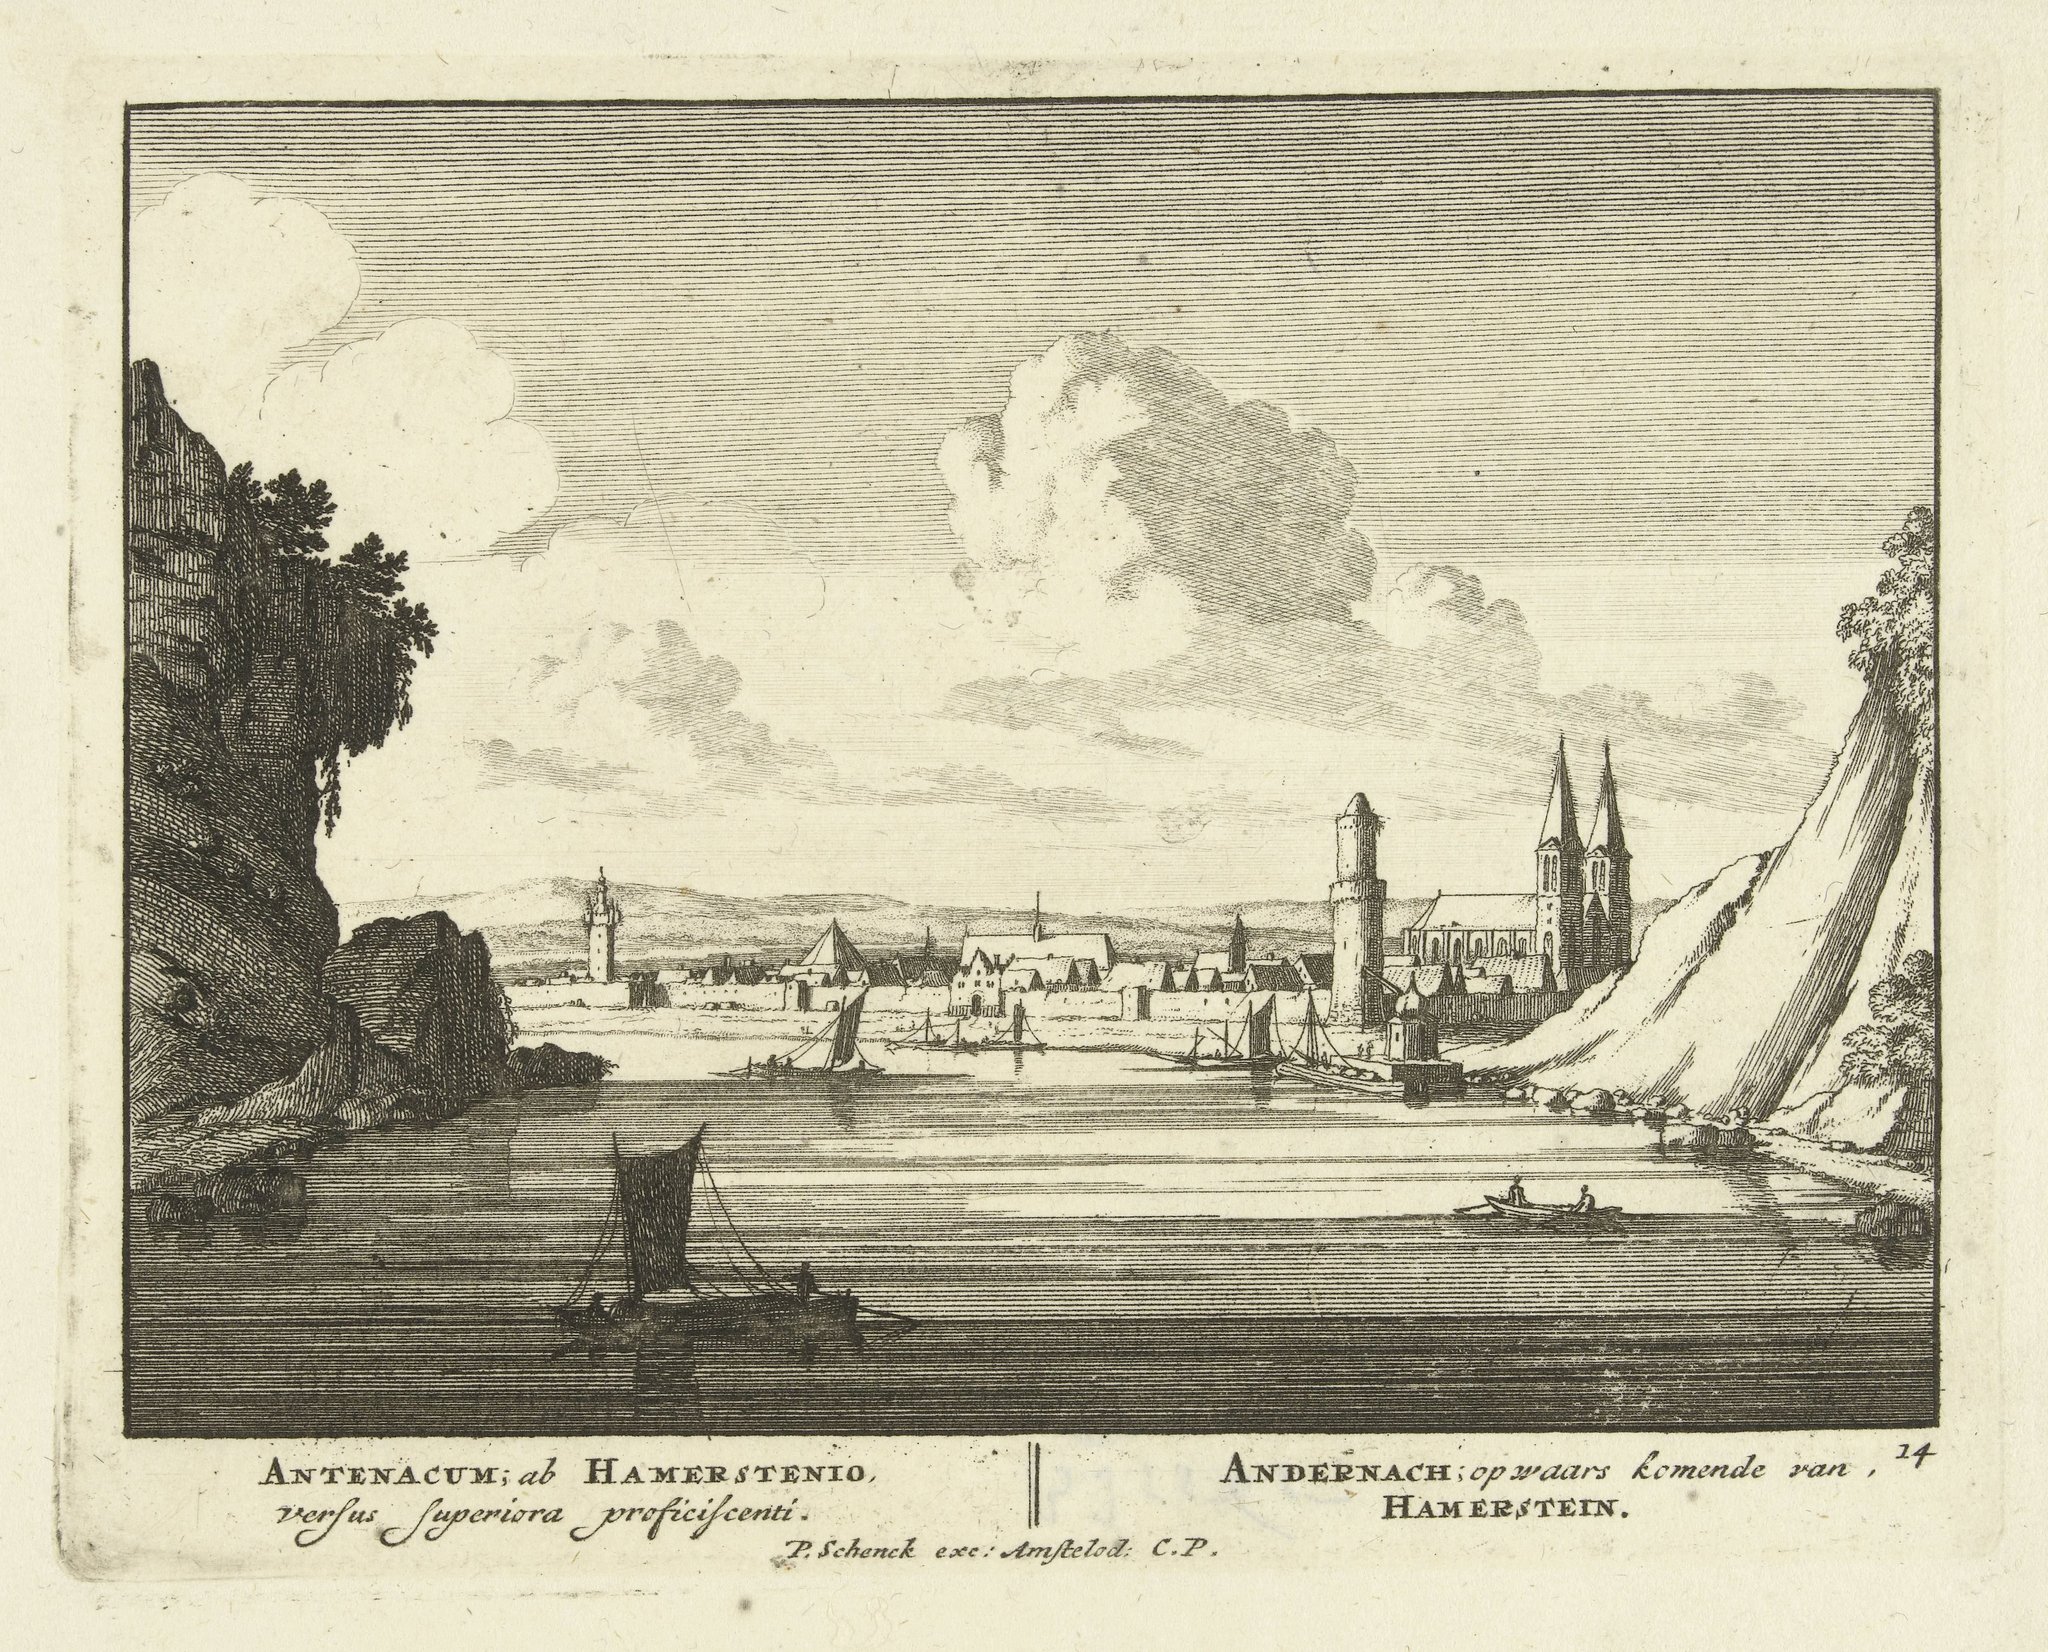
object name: print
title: Gezicht op Andernach aan de Rijn met de Bolle Toren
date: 1694-1697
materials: paper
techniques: etching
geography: amsterdam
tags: river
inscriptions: collector's mark: Lugt 2228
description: Prent uit een serie van 71 prenten met Rijnlandschappen, gezichten op vorstelijke paleizen en stadsgezichten uit Den Haag en Amsterdam.